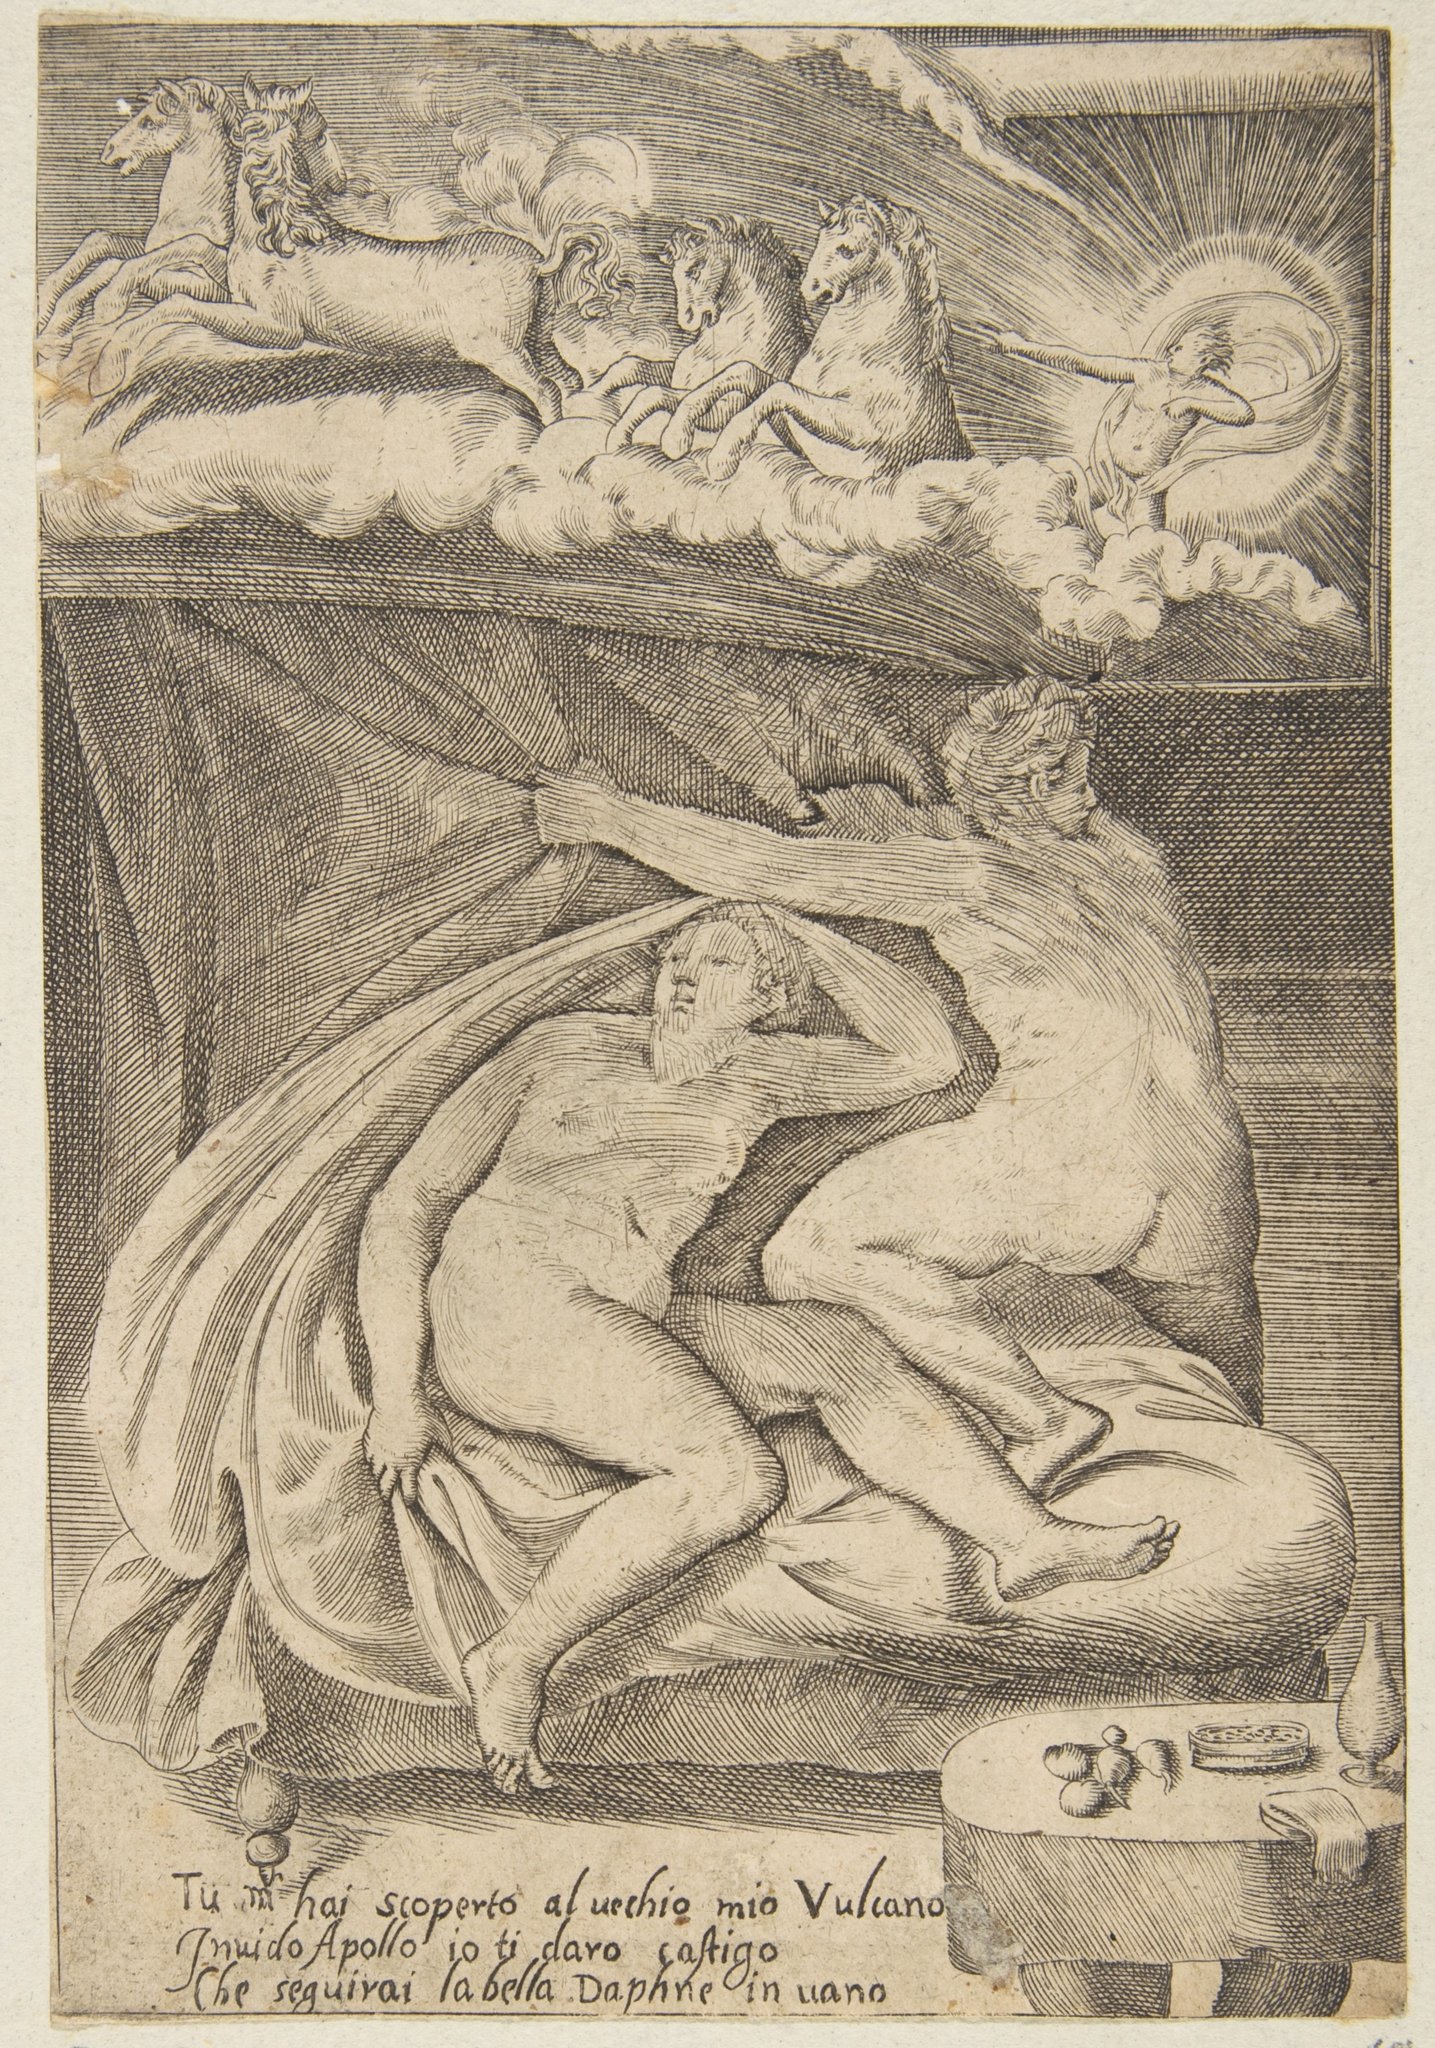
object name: print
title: Venus and Mars discovered by Apollo, from "The Loves of the Gods"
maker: giulio bonasone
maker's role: artist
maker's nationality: italian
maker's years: 1510-1576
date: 1531-1576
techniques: engraving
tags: apollo,mars,venus,horses